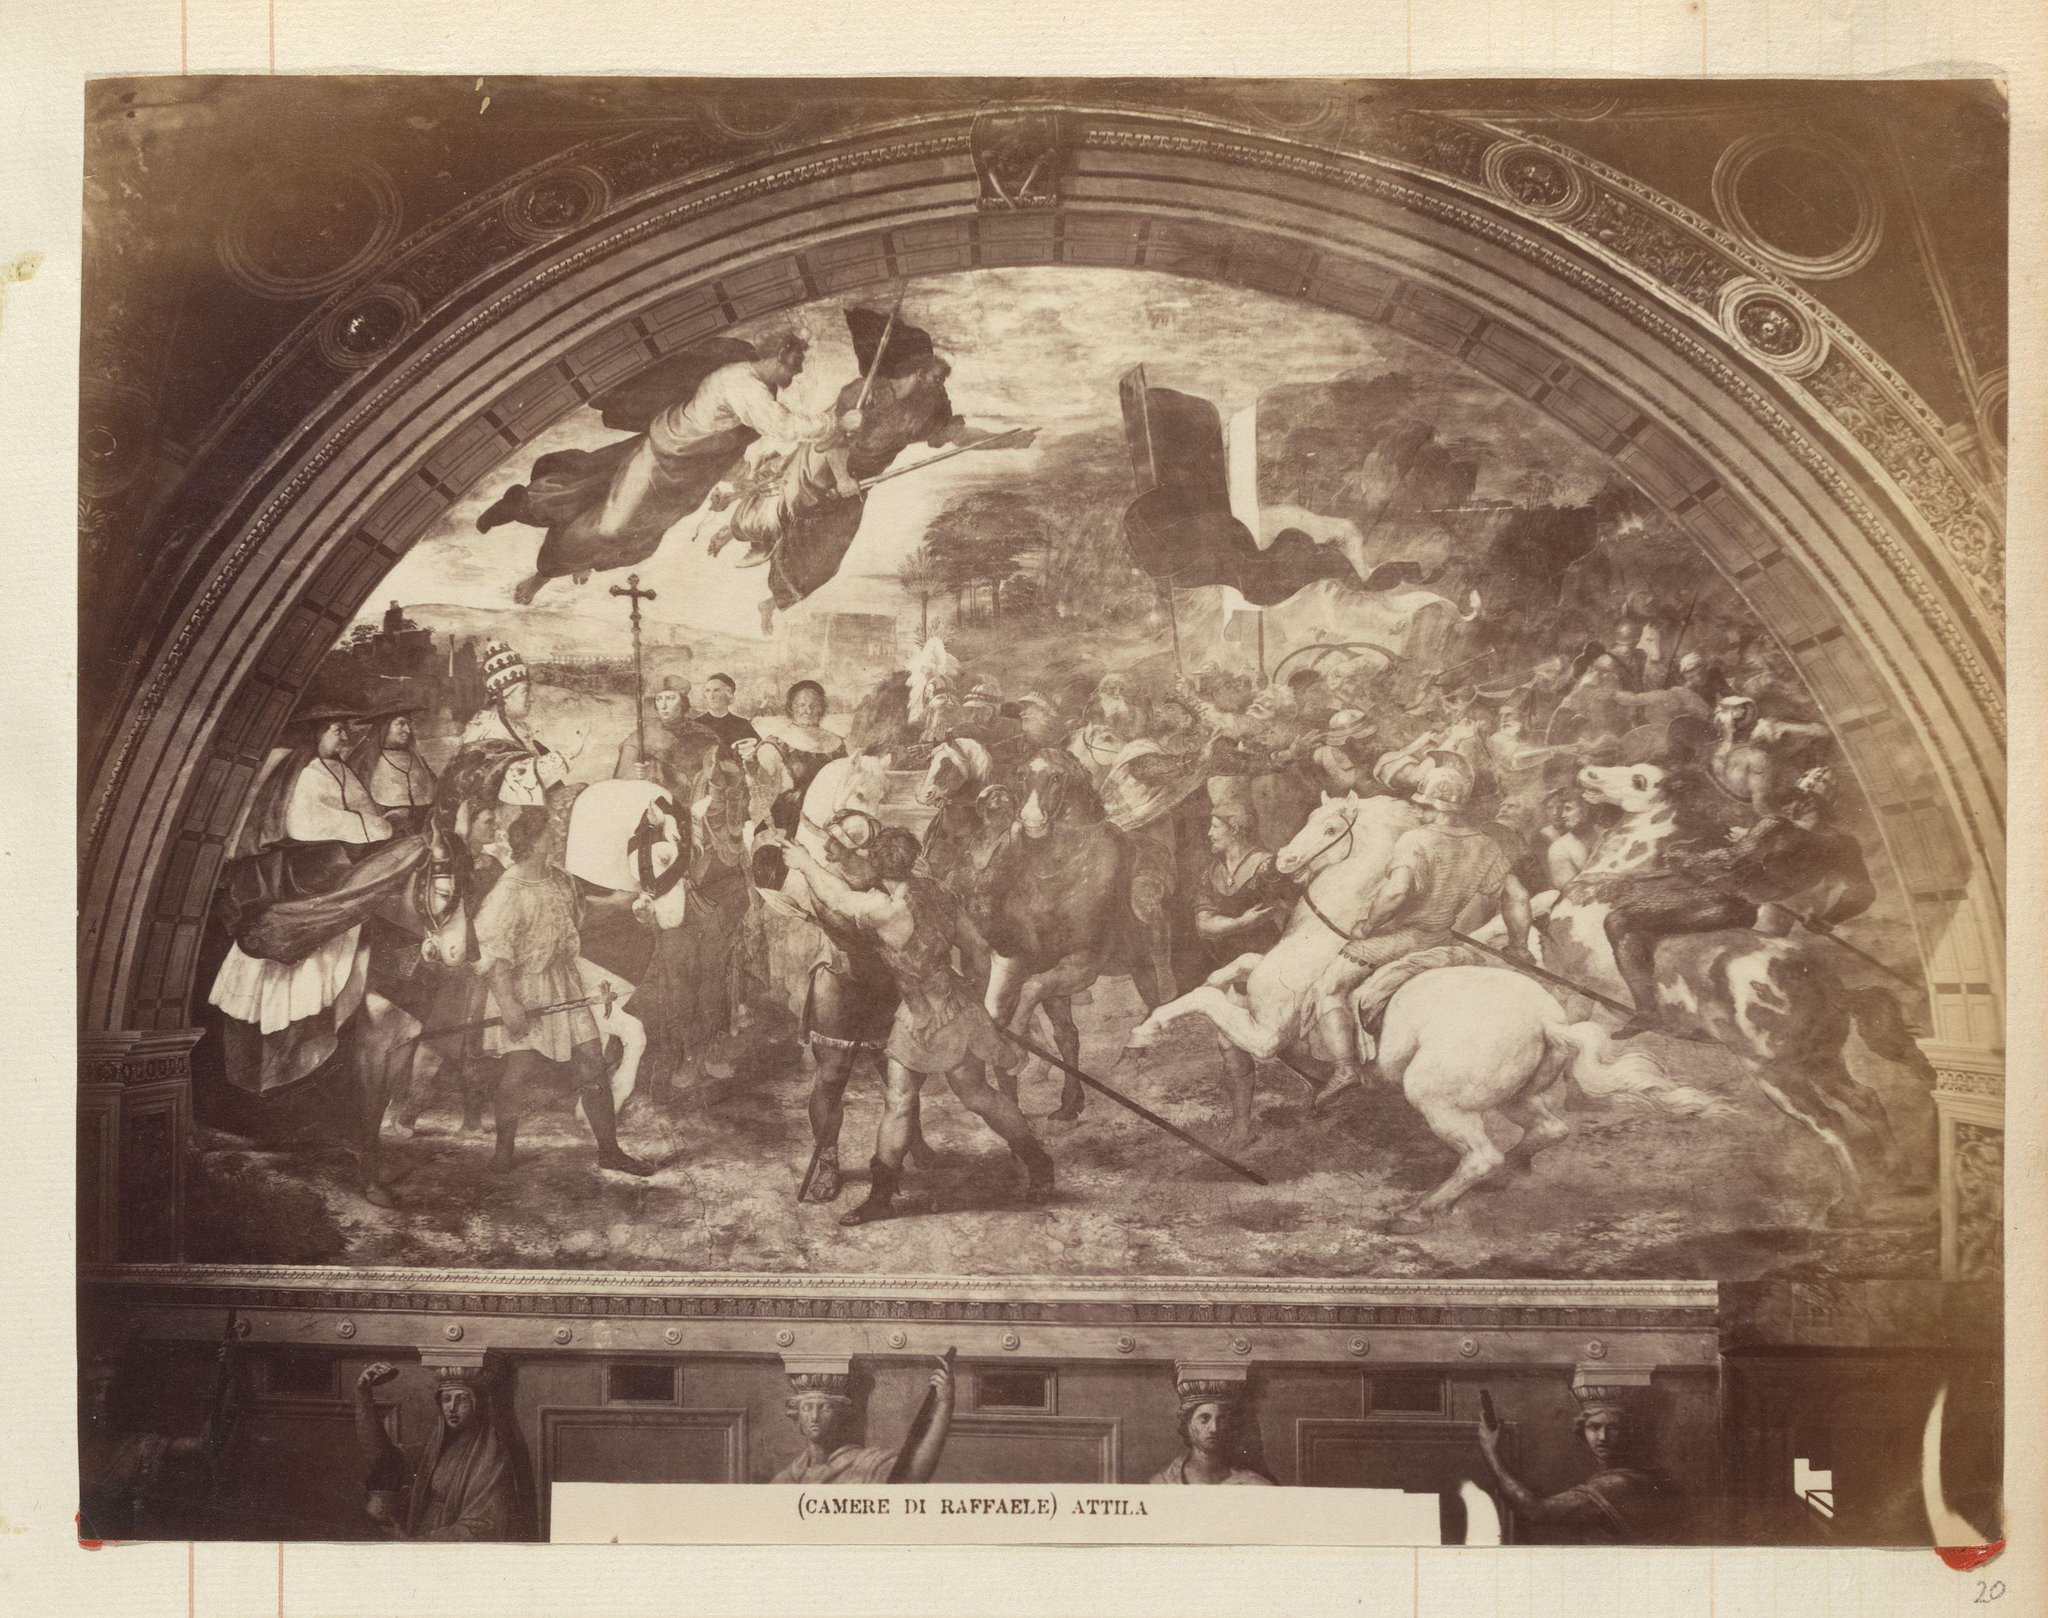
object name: photograph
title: Fresco in het Apostolisch Paleis in Vaticaanstad, voorstellend de ontmoeting van Paus Leo I en Atilla door Rafaël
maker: Anonymous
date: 1880-1900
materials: lacquer, paper, photographic support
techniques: albumen print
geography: apostolisch paleis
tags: painting (including book-illumination, miniature-painting) (+ plaster ~ arts)